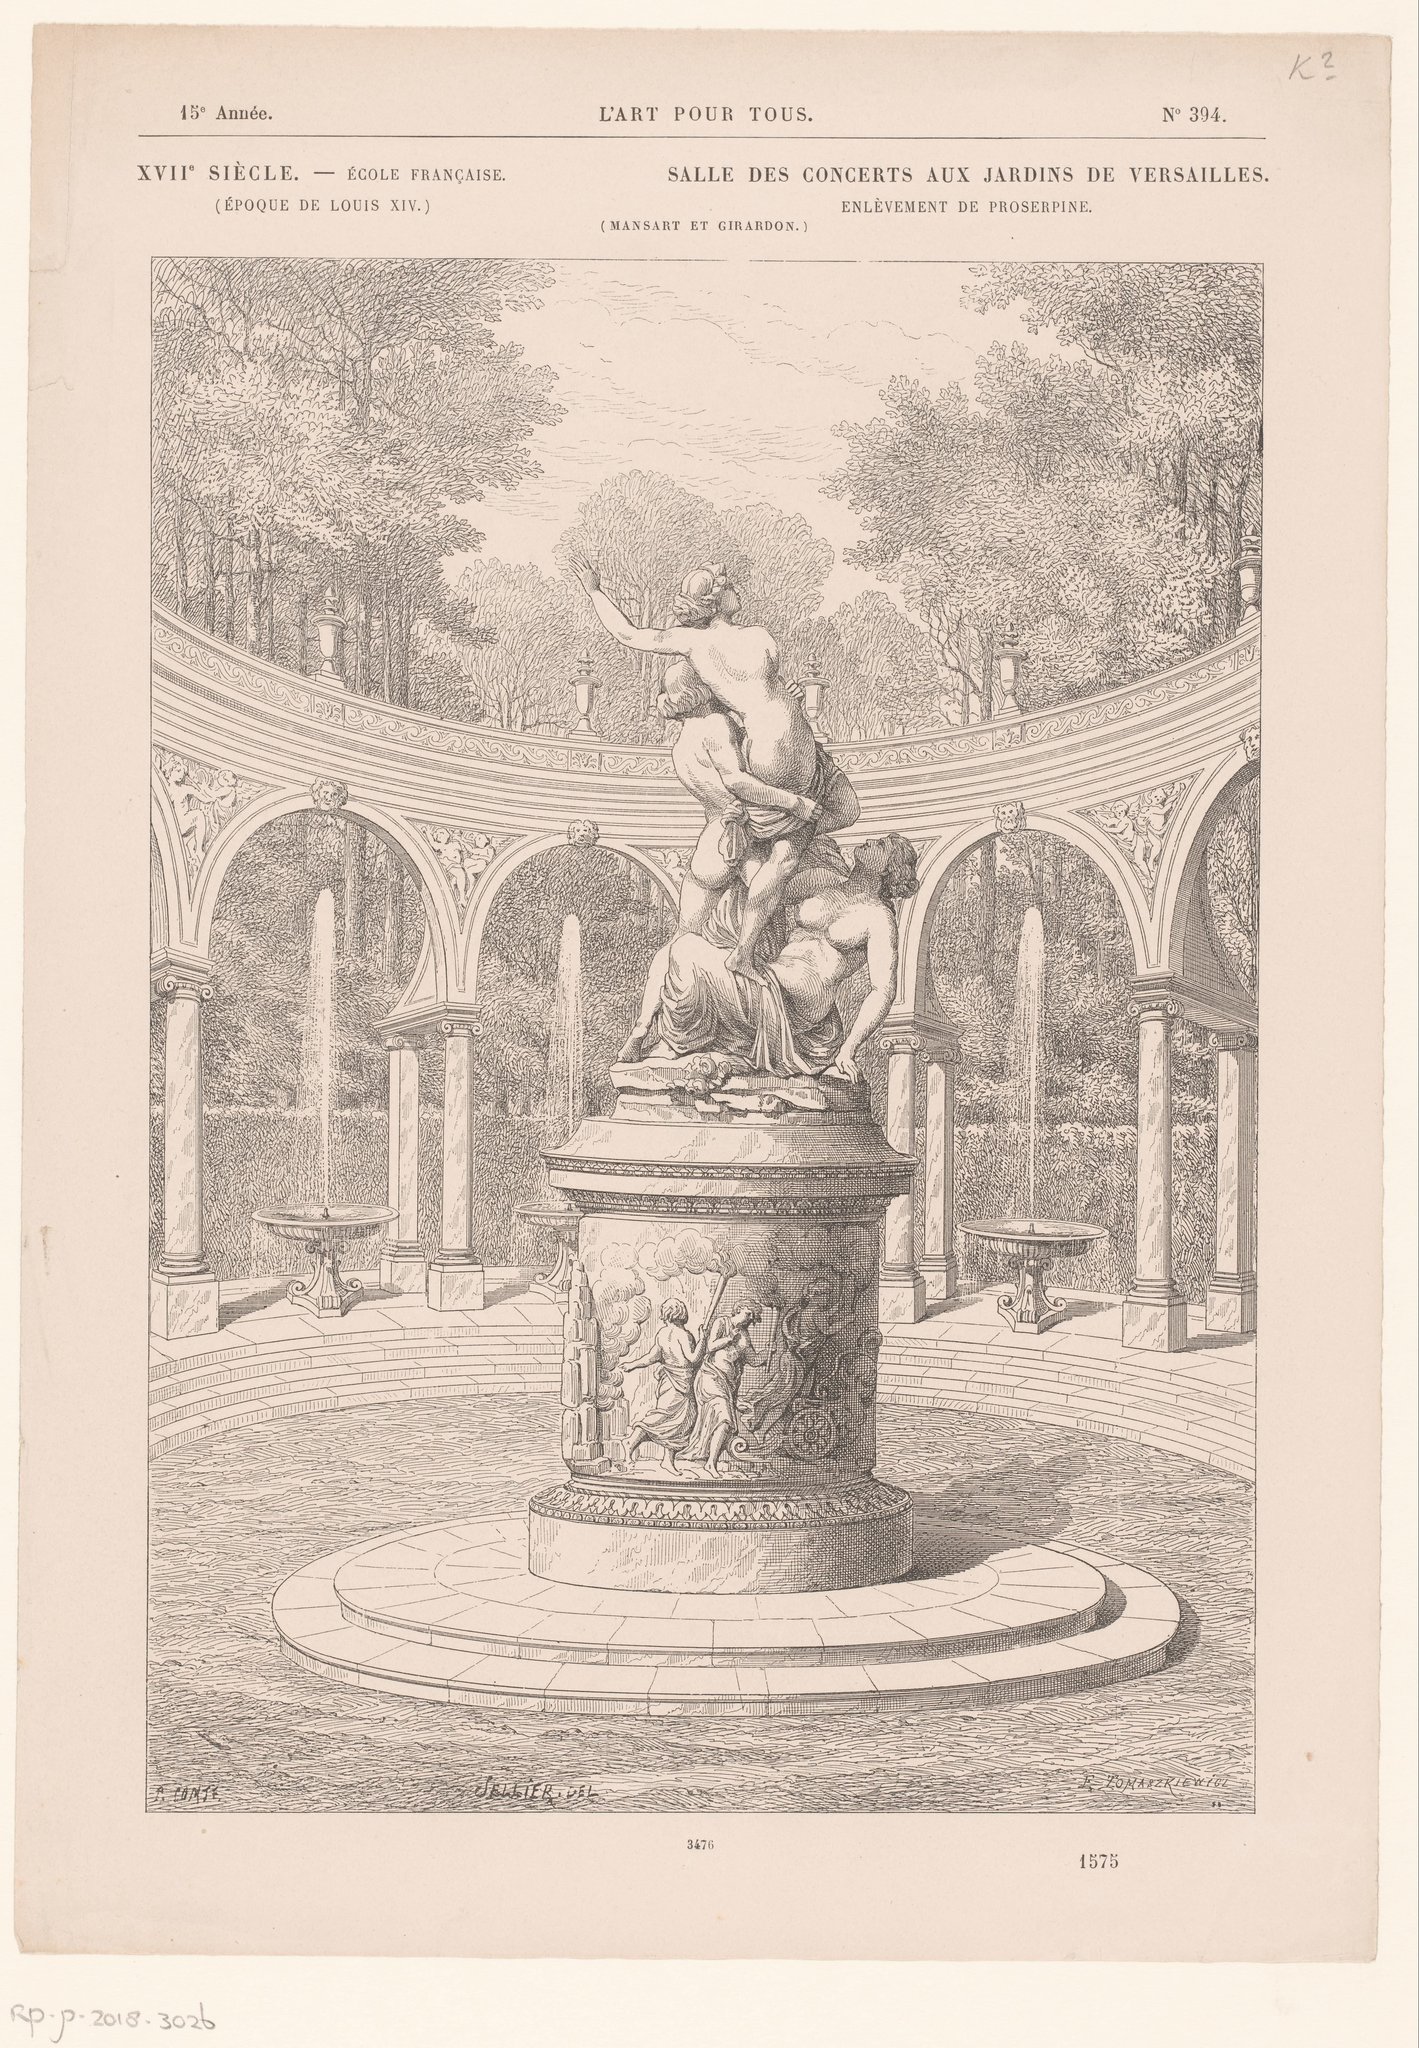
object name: book illustration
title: Salle des Concerts aux Jardins de Versailles: enlèvement de Proserpine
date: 1876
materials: paper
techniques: lithograph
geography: paris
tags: the rape of proserpina (by pluto in his chariot); possibly with diana and minerva trying to rescue her, statues, sculptures in garden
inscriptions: collector's mark: Lugt 2228, collector's mark: Lugt 3937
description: Prent uit: Sauvageot (ed.). L'Art Pour Tous, encyclopédie de l'art industriel et decoratif. Parijs: Morel, 1861-1905, nr. 394 (1876).